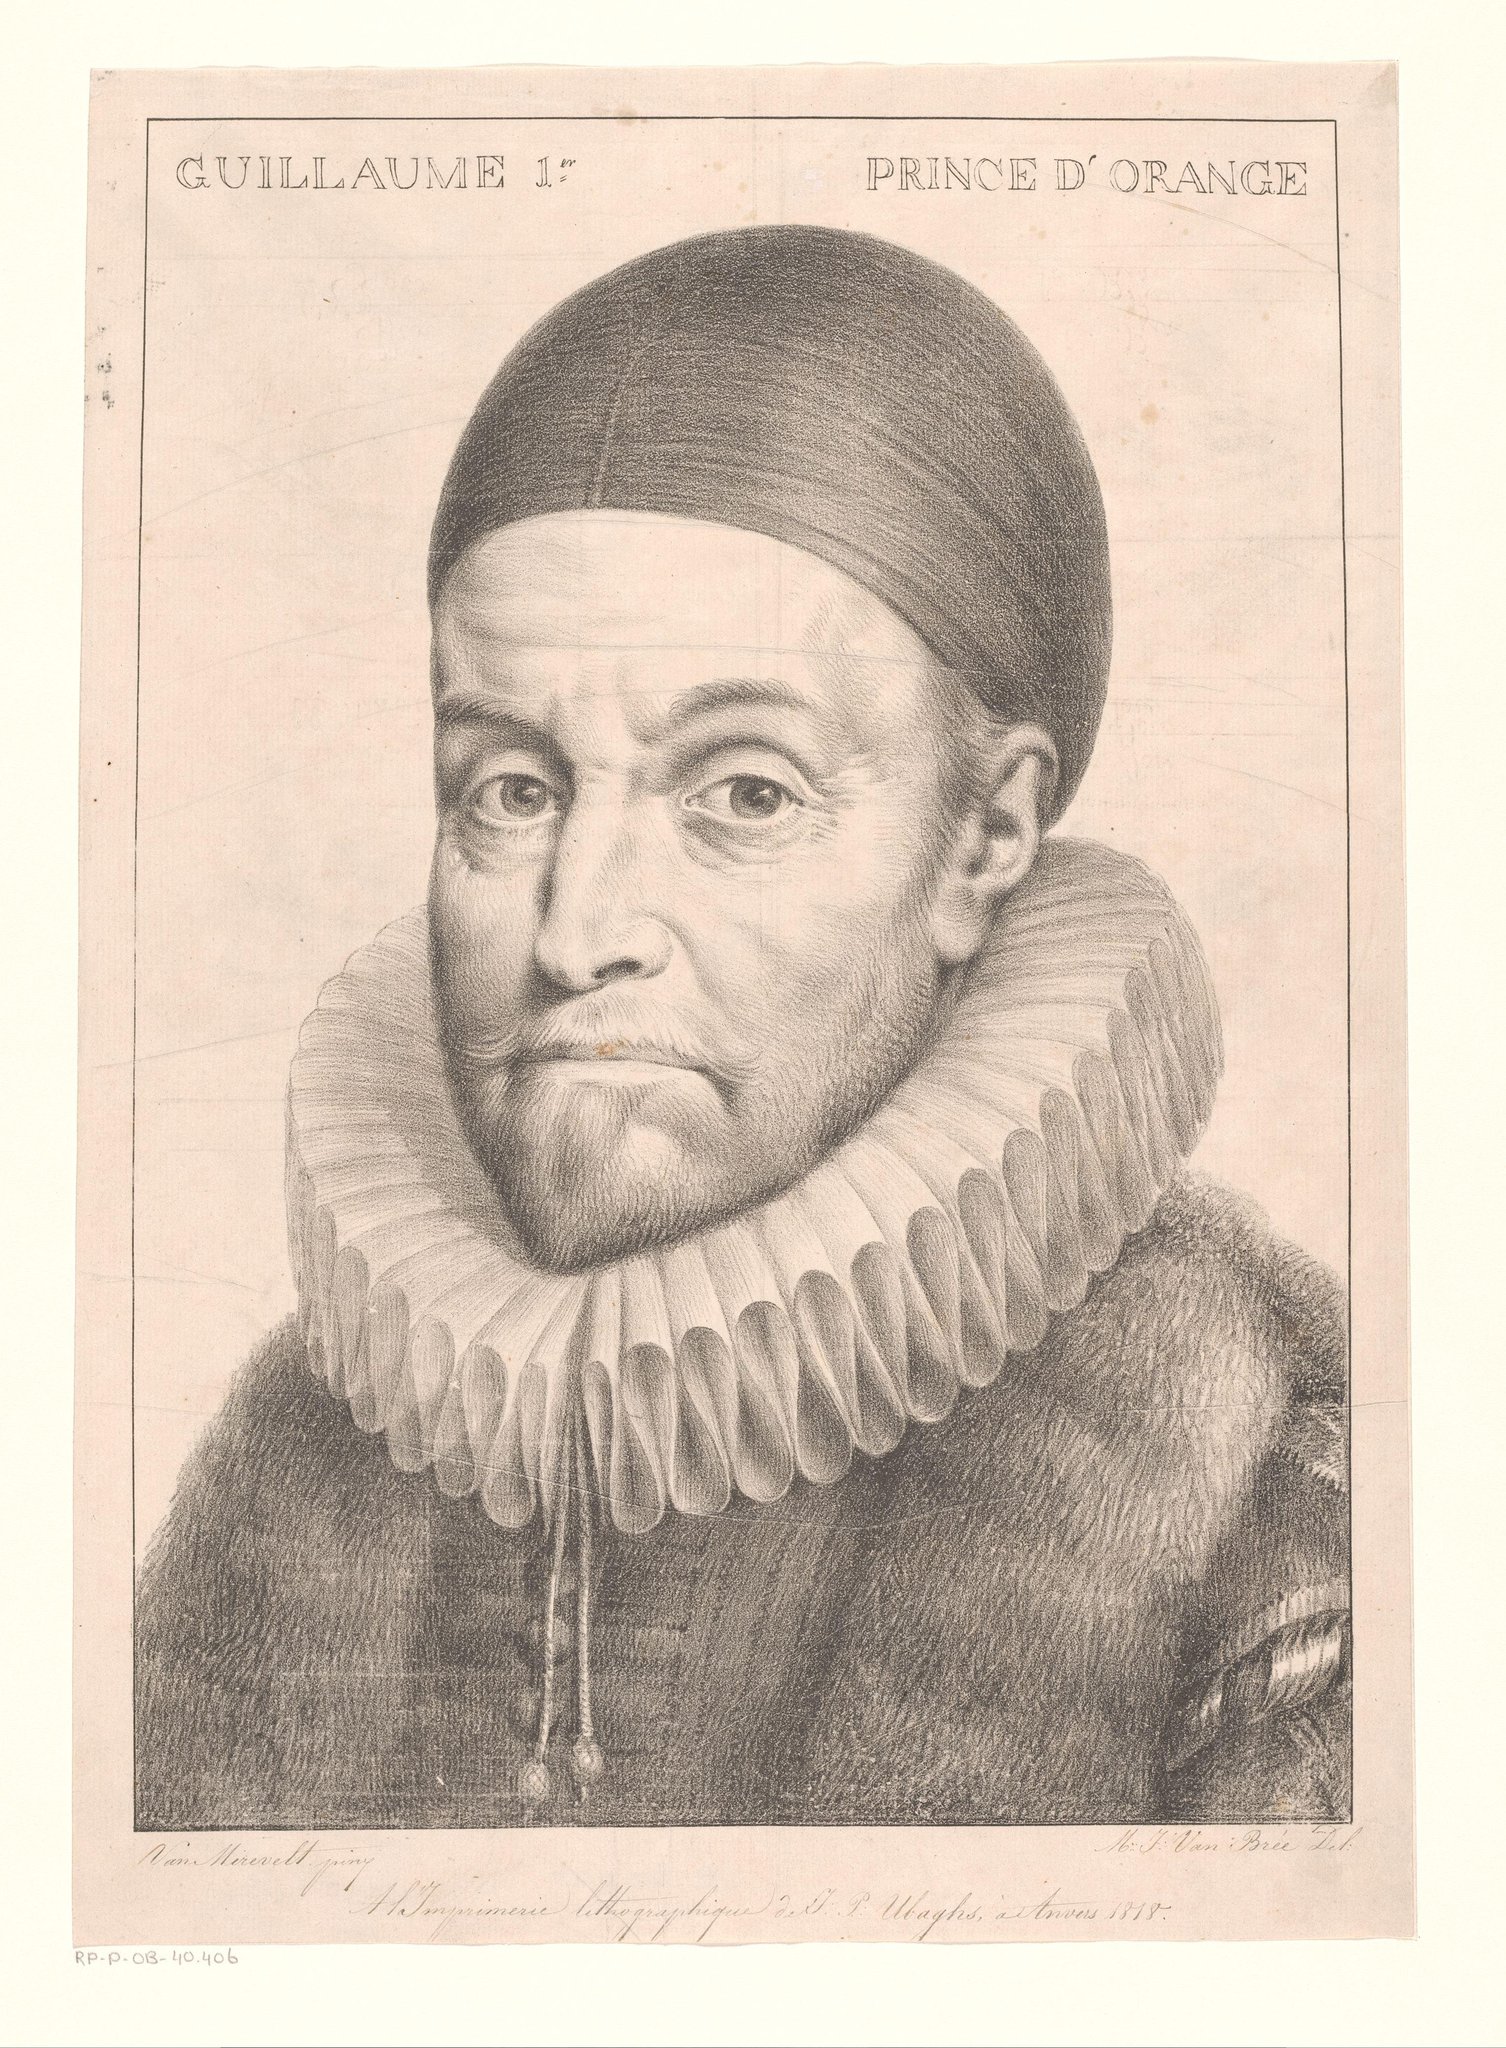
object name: print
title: Guillaume Ier /Prince d'Orange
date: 1818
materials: paper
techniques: lithograph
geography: antwerp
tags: delft, william i (prince of orange), historical persons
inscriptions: watermark